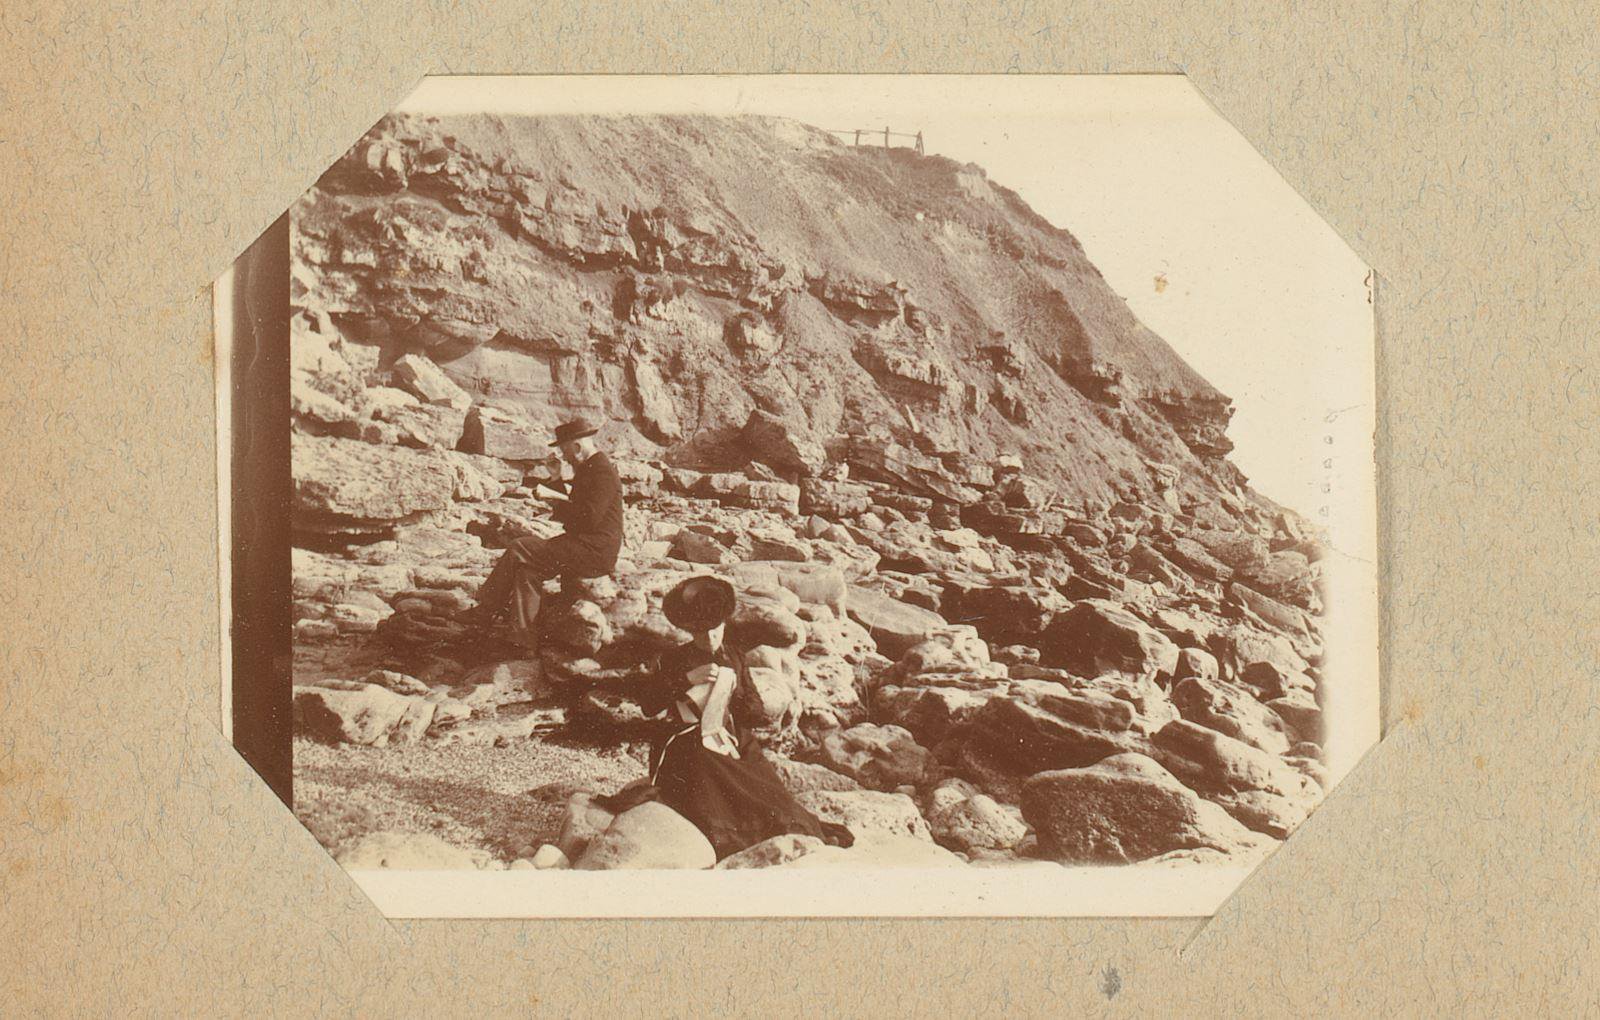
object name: photograph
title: Lezende man en vrouw met handwerk tussen rotsen aan de kust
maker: Anonymous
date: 1897-1900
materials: paper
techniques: gelatin silver print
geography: france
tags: reading, rocky coast, (other forms of) needlework, e.g.: crocheting, knitting, embroidering, france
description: Over de foto is een ander negatief afgedrukt van een voorstelling van bomen.